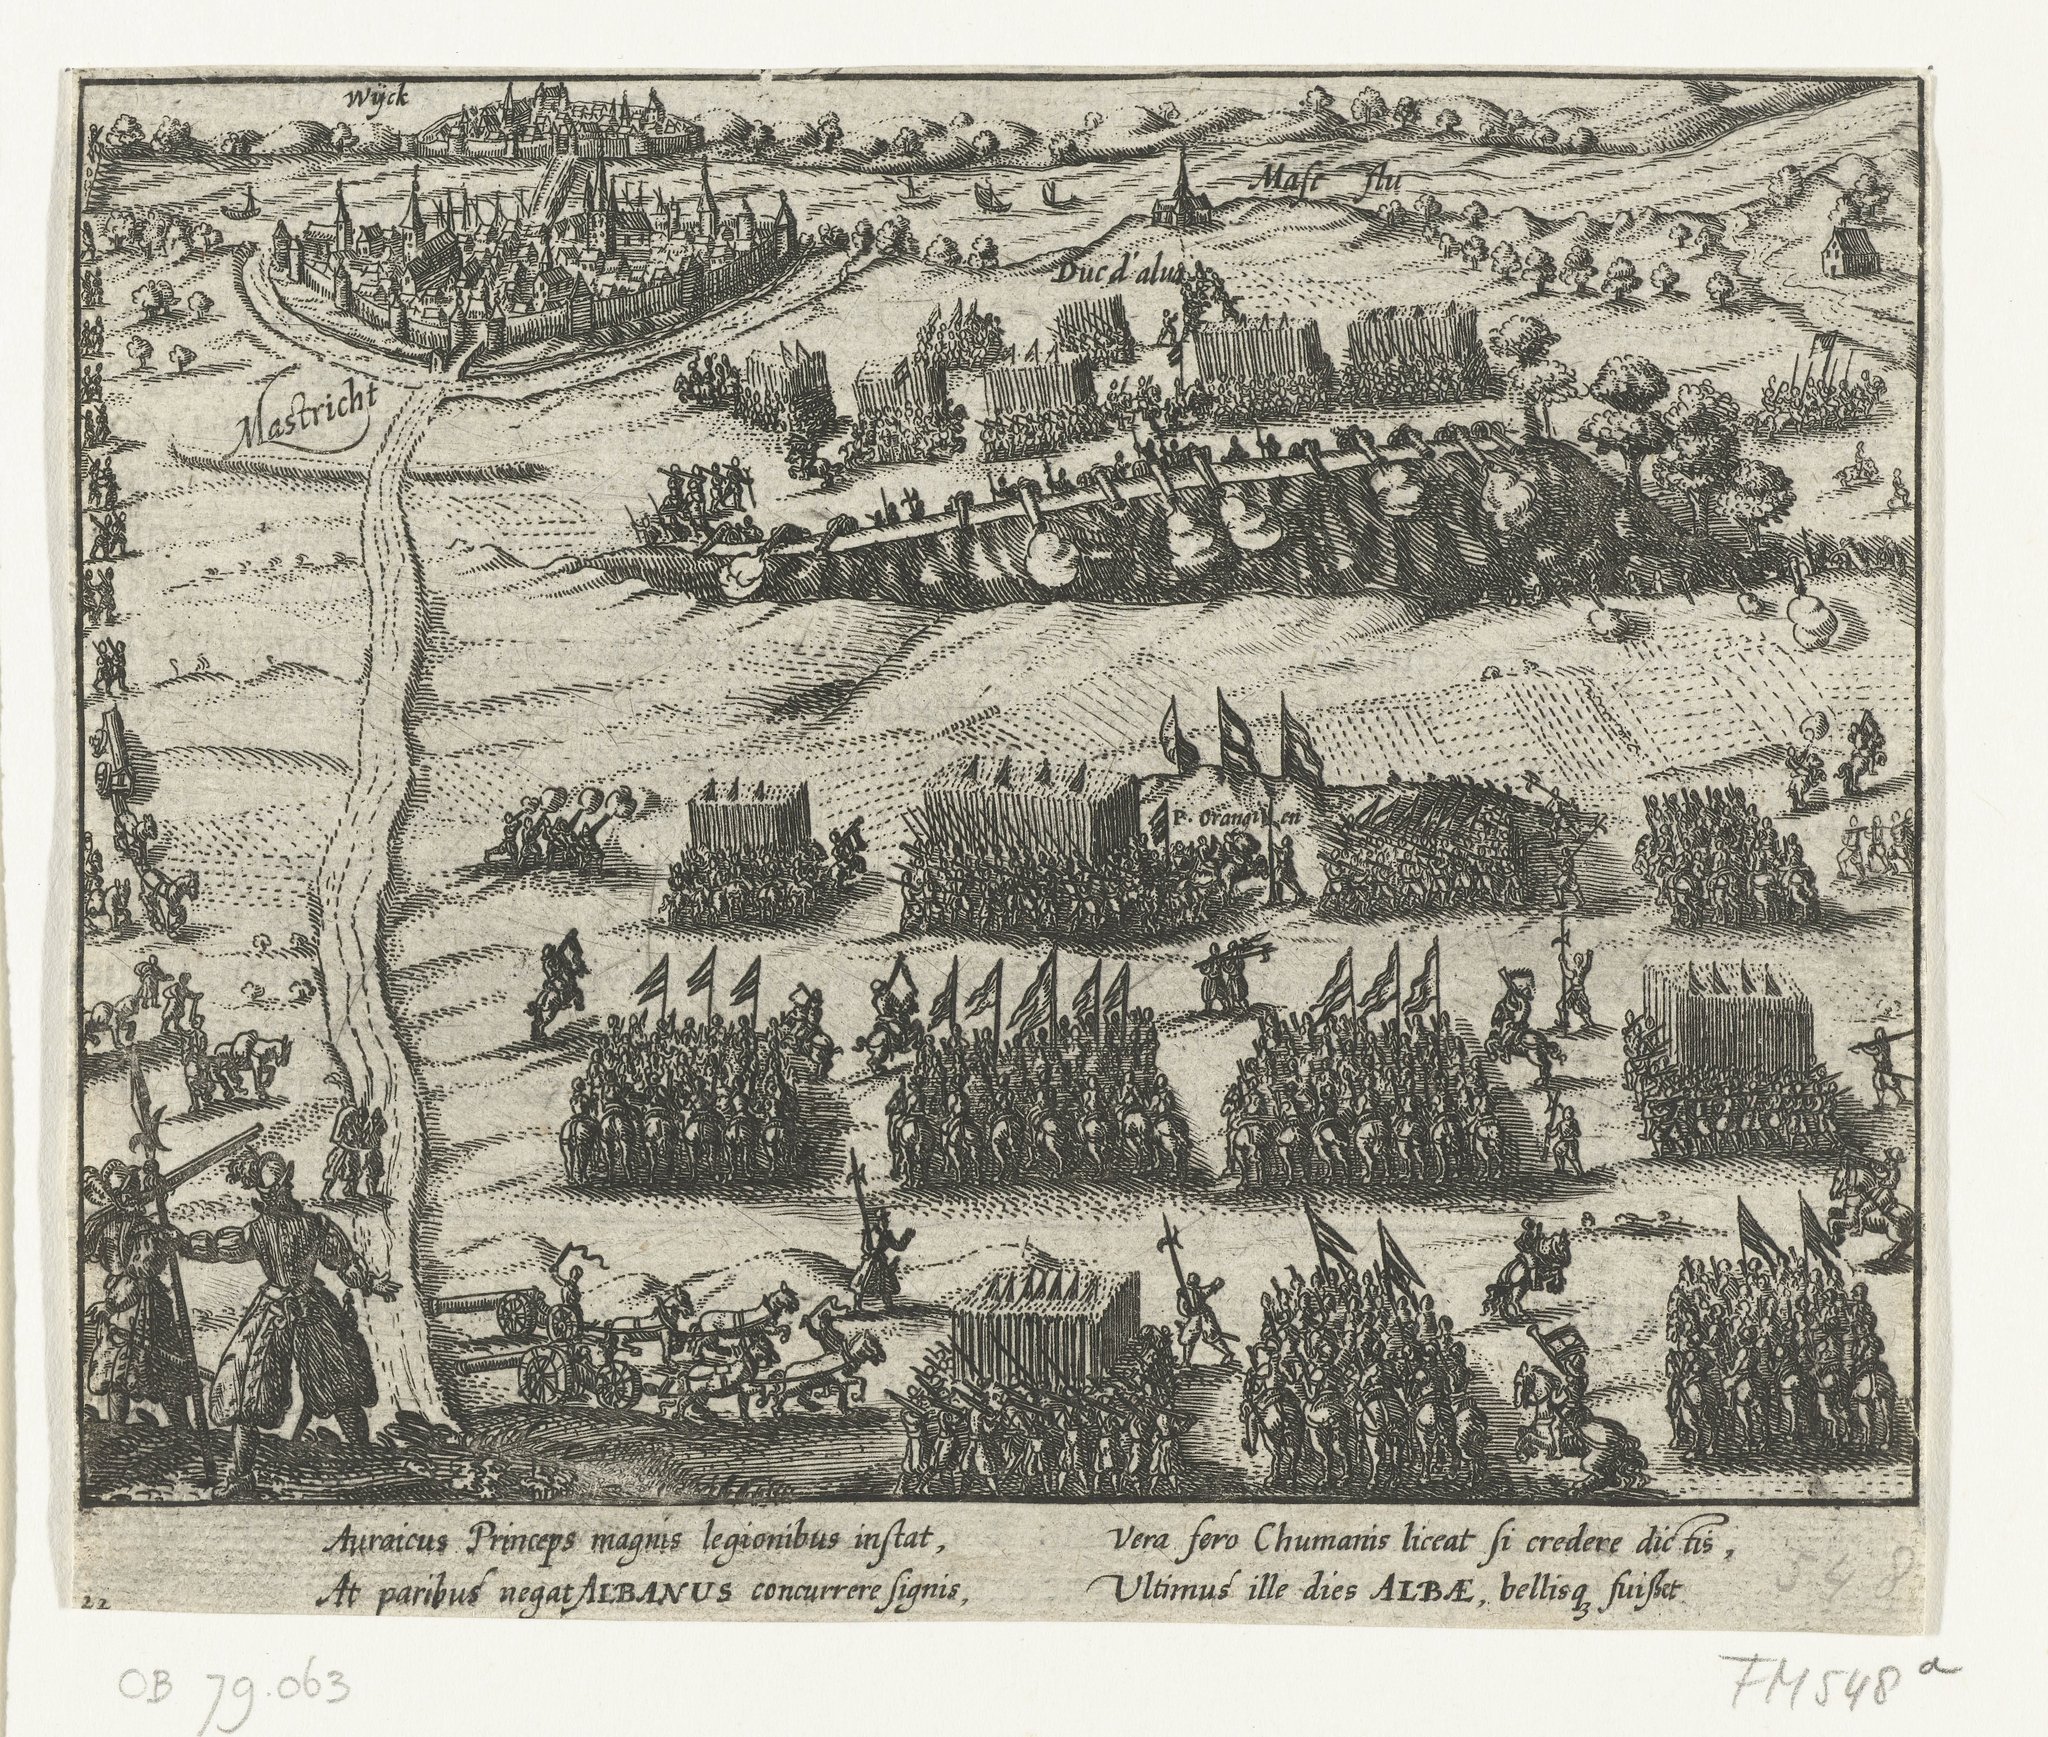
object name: history print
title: Prins van Oranje trekt over de Maas, 1568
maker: Anonymous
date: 1613-1615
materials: paper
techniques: etching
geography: germany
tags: delft, william i (prince of orange), fernando álvarez de toledo (3rd duke of alba), army 'en route' (+ land forces), maastricht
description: Prins van Oranje trekt over de Maas, oktober 1568. Het leger van de prins tegenover het leger van Alva, in de verte de Maas en Maastricht. Met onderschrift van 4 regels in het Latijn. Genummerd: 22. Bedrukt op achterzijde met tekst in het Latijn.